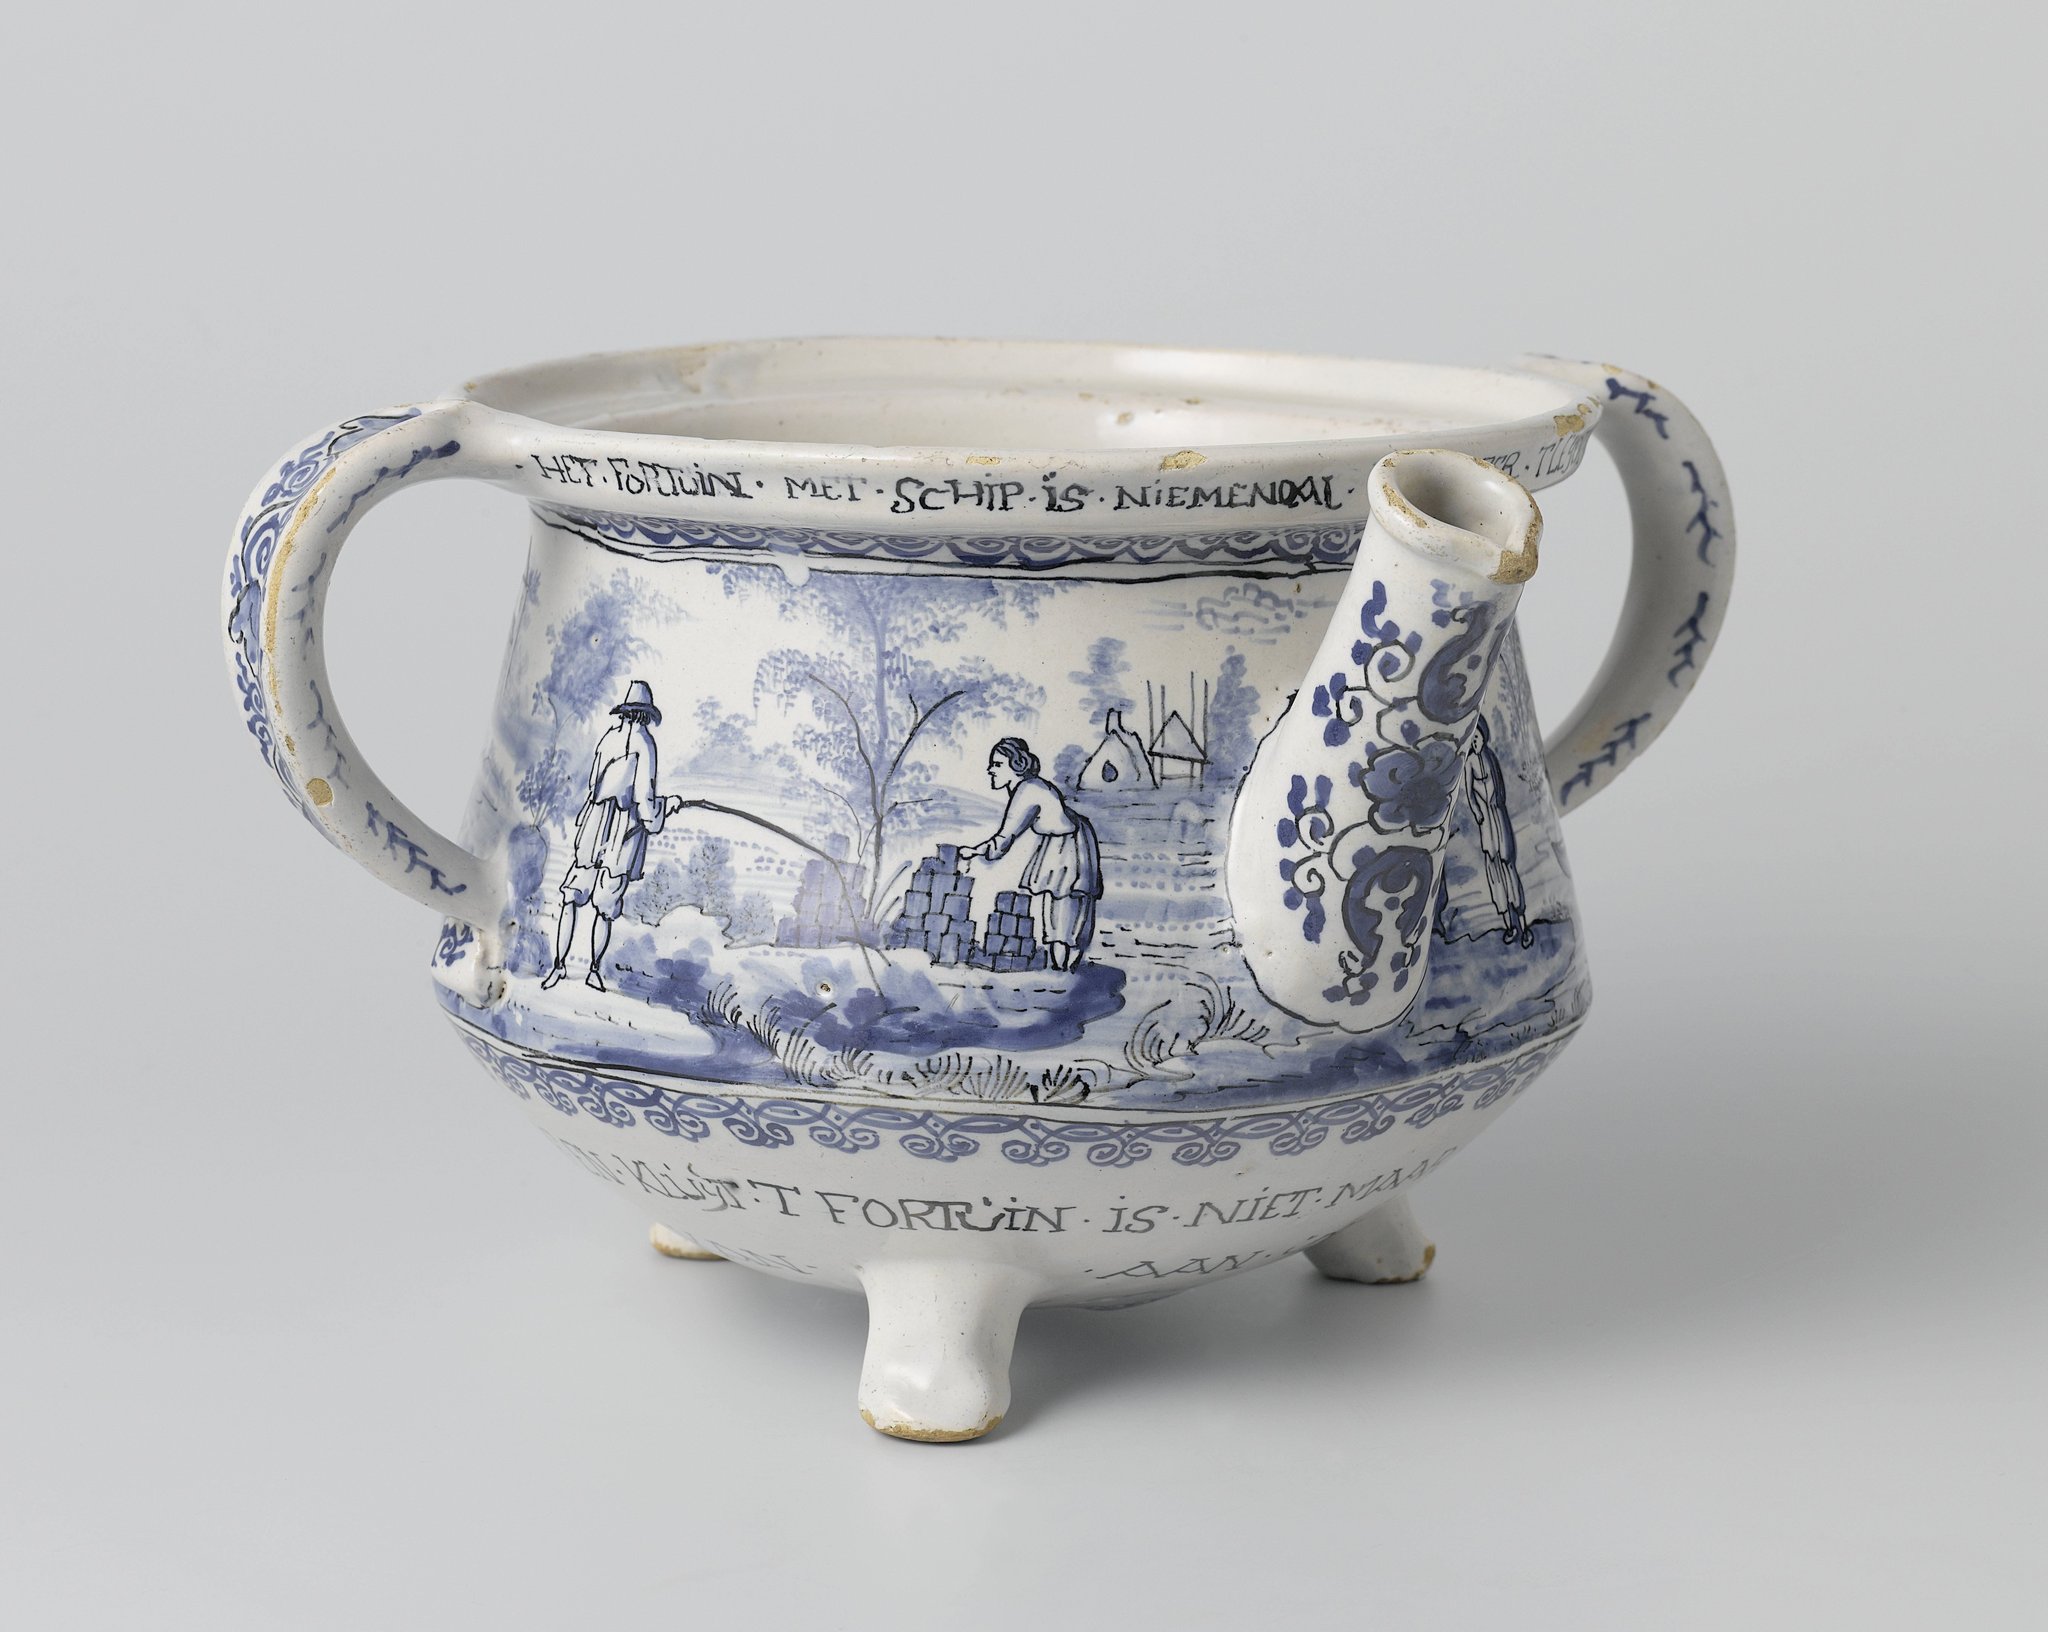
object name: roompot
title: Roompot, beschilderd met scènes uit het turfschippersbedrijf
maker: Anonymous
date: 1700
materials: faience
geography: delft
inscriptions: inscription: ‘'T FORTUIN - IS - NIET - MAAR - GODT - IST - AL - DIE - DEN - SEGEN - GEVEN - SAL - ICK - VERKOOP - TURF - EN KLUYT - AAN - YDER - MAN - SOO - GOEDT - KOOP - ALS - ICK - KAN’, inscription: ‘WANNEER ALS - WIJ - KOOMEN - OP - RIJVIERE - HEBBEN - WIJ - MET TSCHIP - PLEISIERE. --HET FORTUIN - MET -- SCHIP - IS - NIEMENDAL - WANNEER 'T LEYDT AN DE WAL’, date: ‘1700’, inscription: ‘UYT LIEFDE GEPIJNDT’, inscription: ‘8m’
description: Roompot van faience, beschilderd in blauw met scènes uit het turfschippersbedrijf.